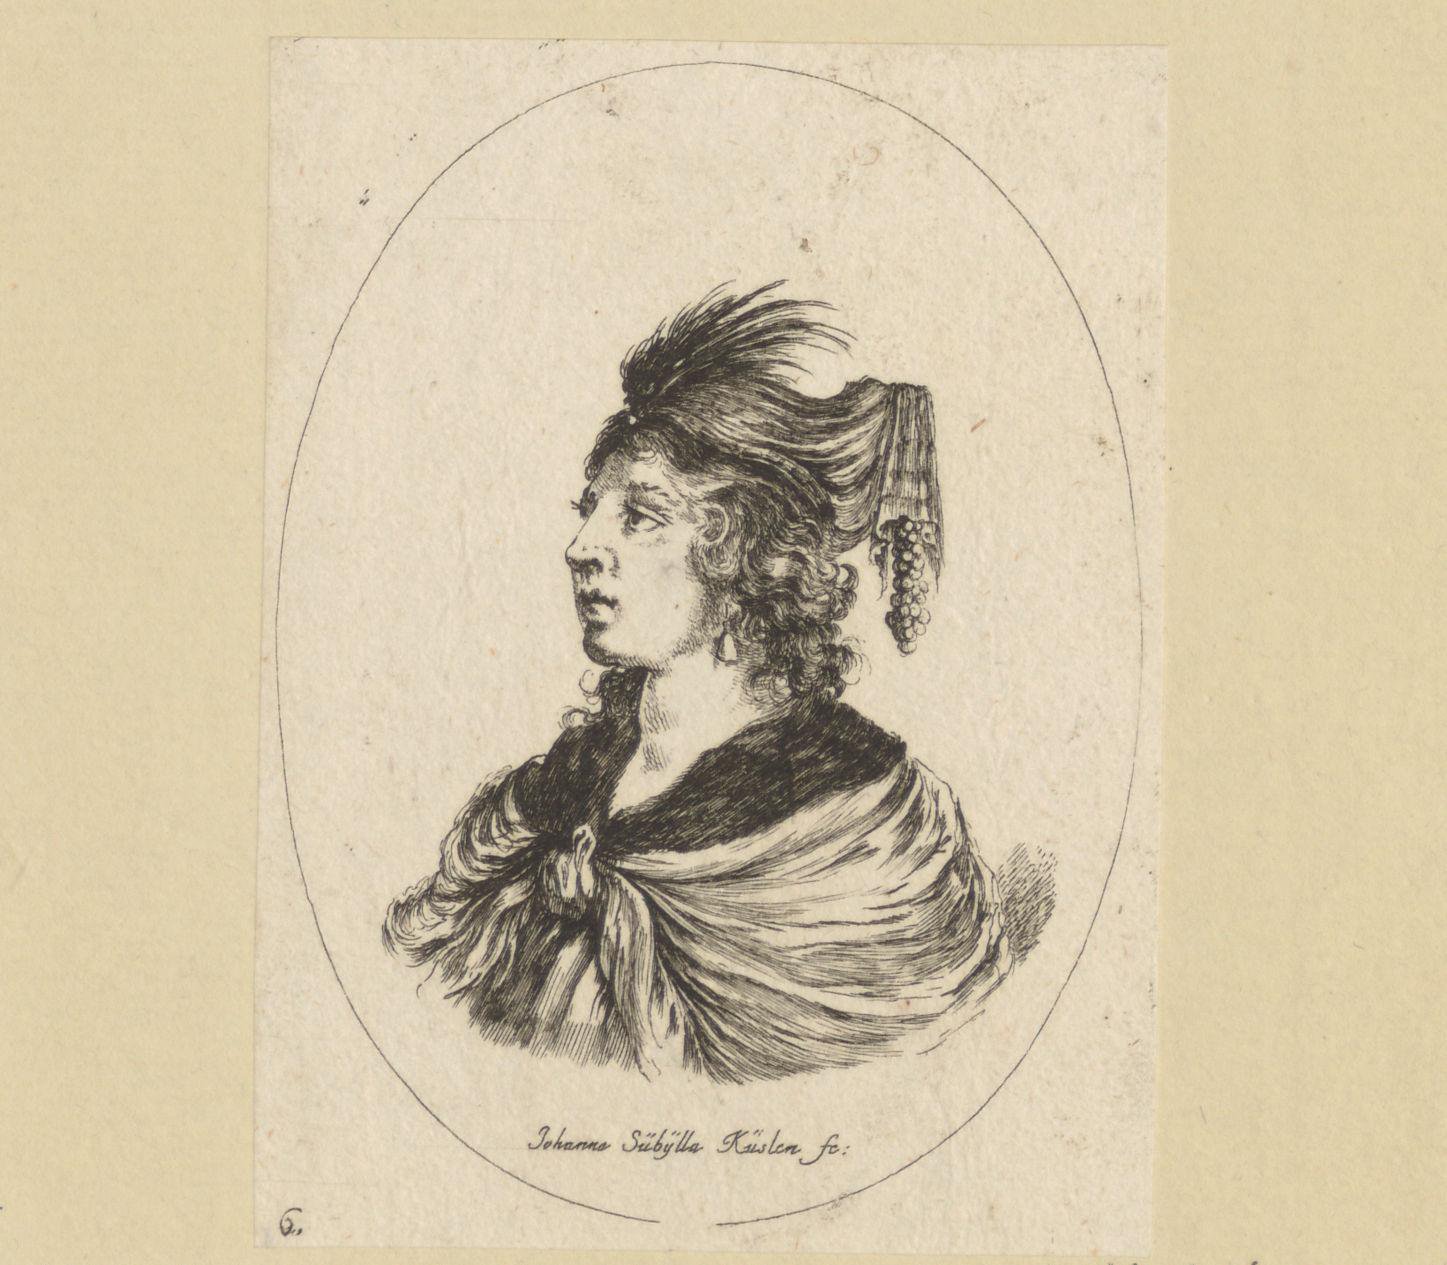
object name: print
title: Portret van een onbekende man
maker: johanna sibilla küsel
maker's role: print maker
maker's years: 1650-1717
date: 1660-1717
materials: paper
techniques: etching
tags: head-gear: turban, anonymous historical person portrayed, folk costume, regional costume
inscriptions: collector's mark: Lugt 2228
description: Deze prent maakt deel uit van een serie van in ieder geval zeven prenten.